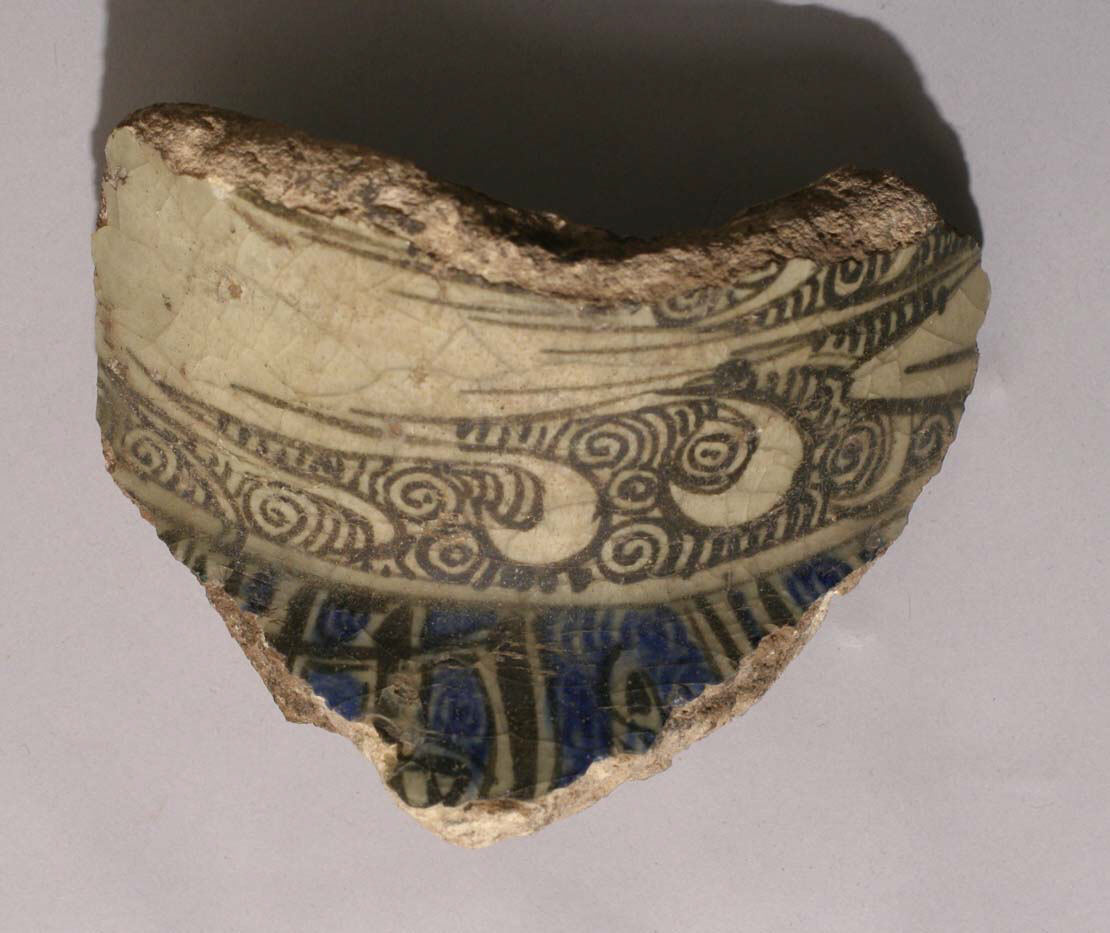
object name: fragment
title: Ceramic Fragment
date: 1301-1400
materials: stonepaste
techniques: painting, polychrome, underglaze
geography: syria